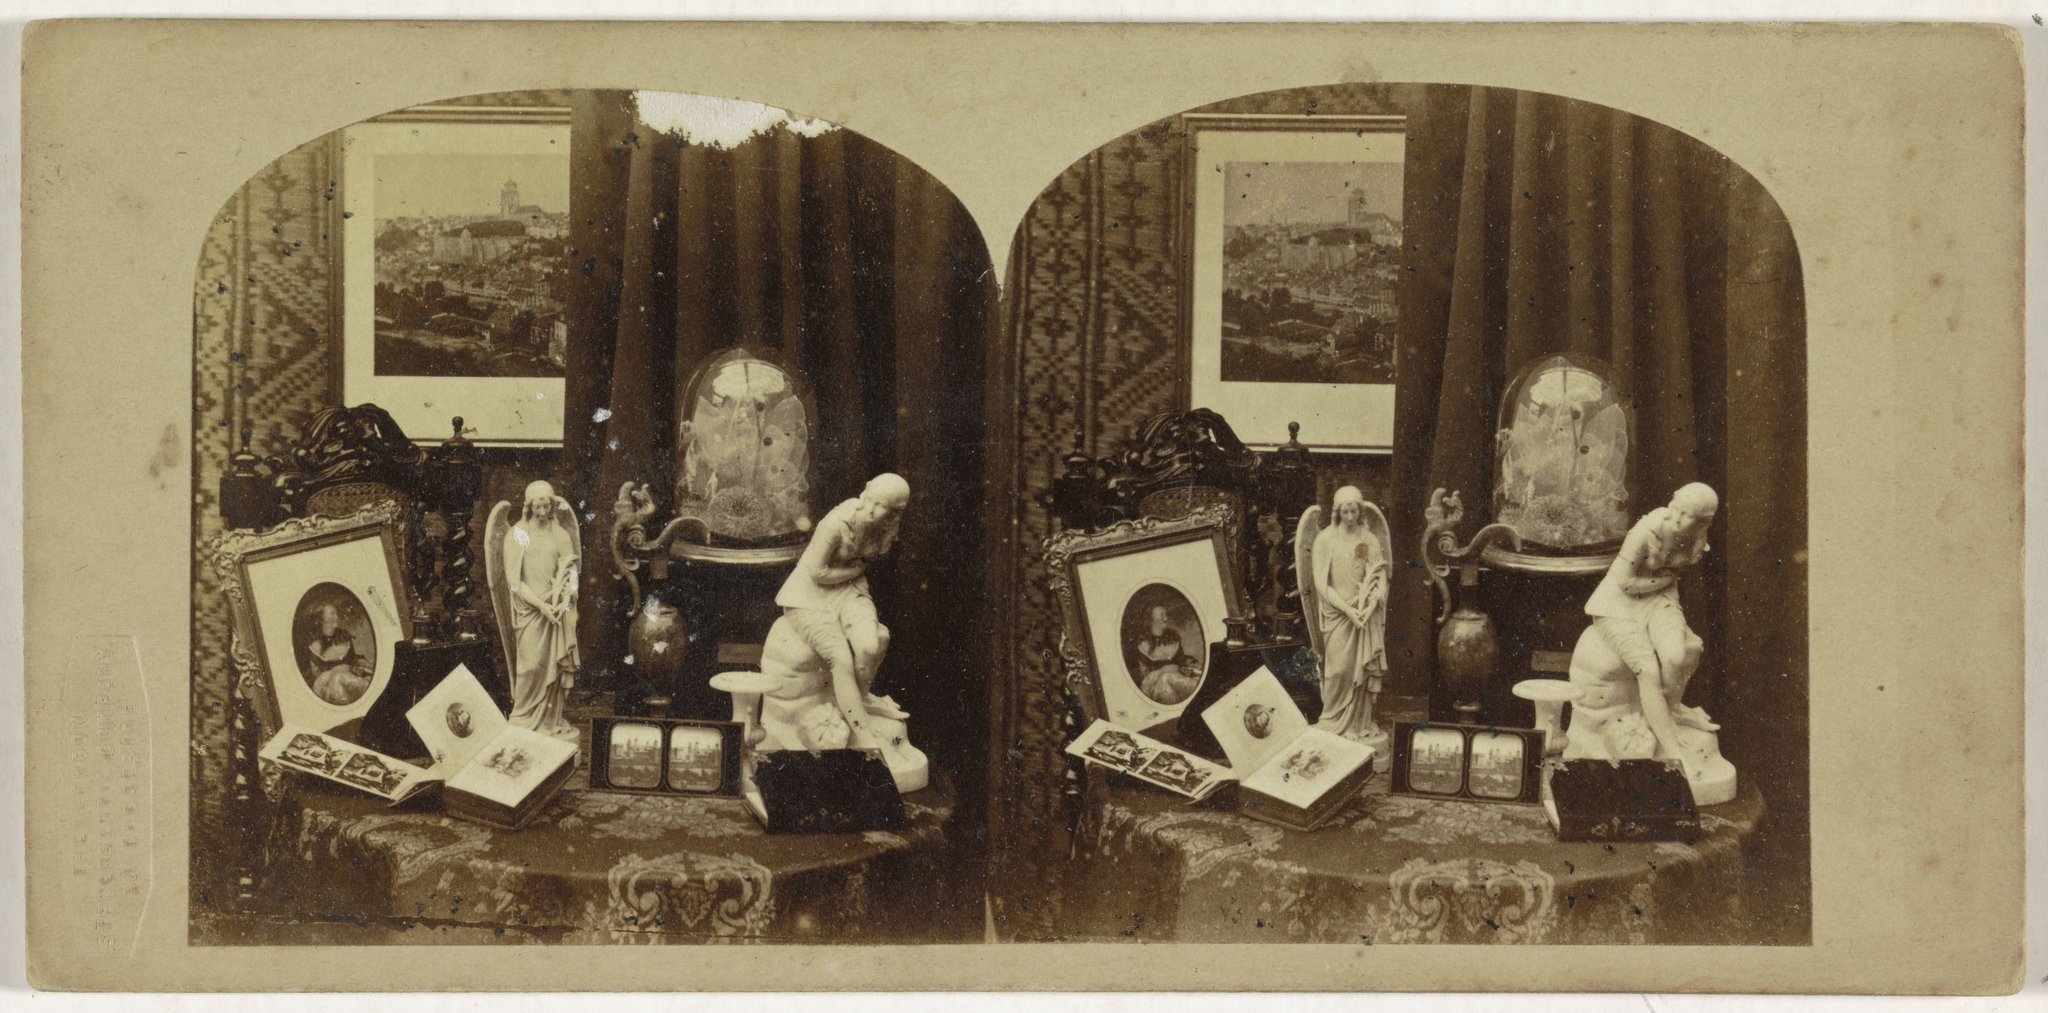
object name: stereograph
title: Foto's en beelden op een tafel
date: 1856-1922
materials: cardboard, paper, photographic support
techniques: albumen print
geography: london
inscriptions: label: ‘Artistic Group.’, check stamp: ‘The London Stereoscopic Company 54 Cheapside’, annotation: ‘geschenk van Louh Tilaun (?) Leiden 21-V-2001 (?)’